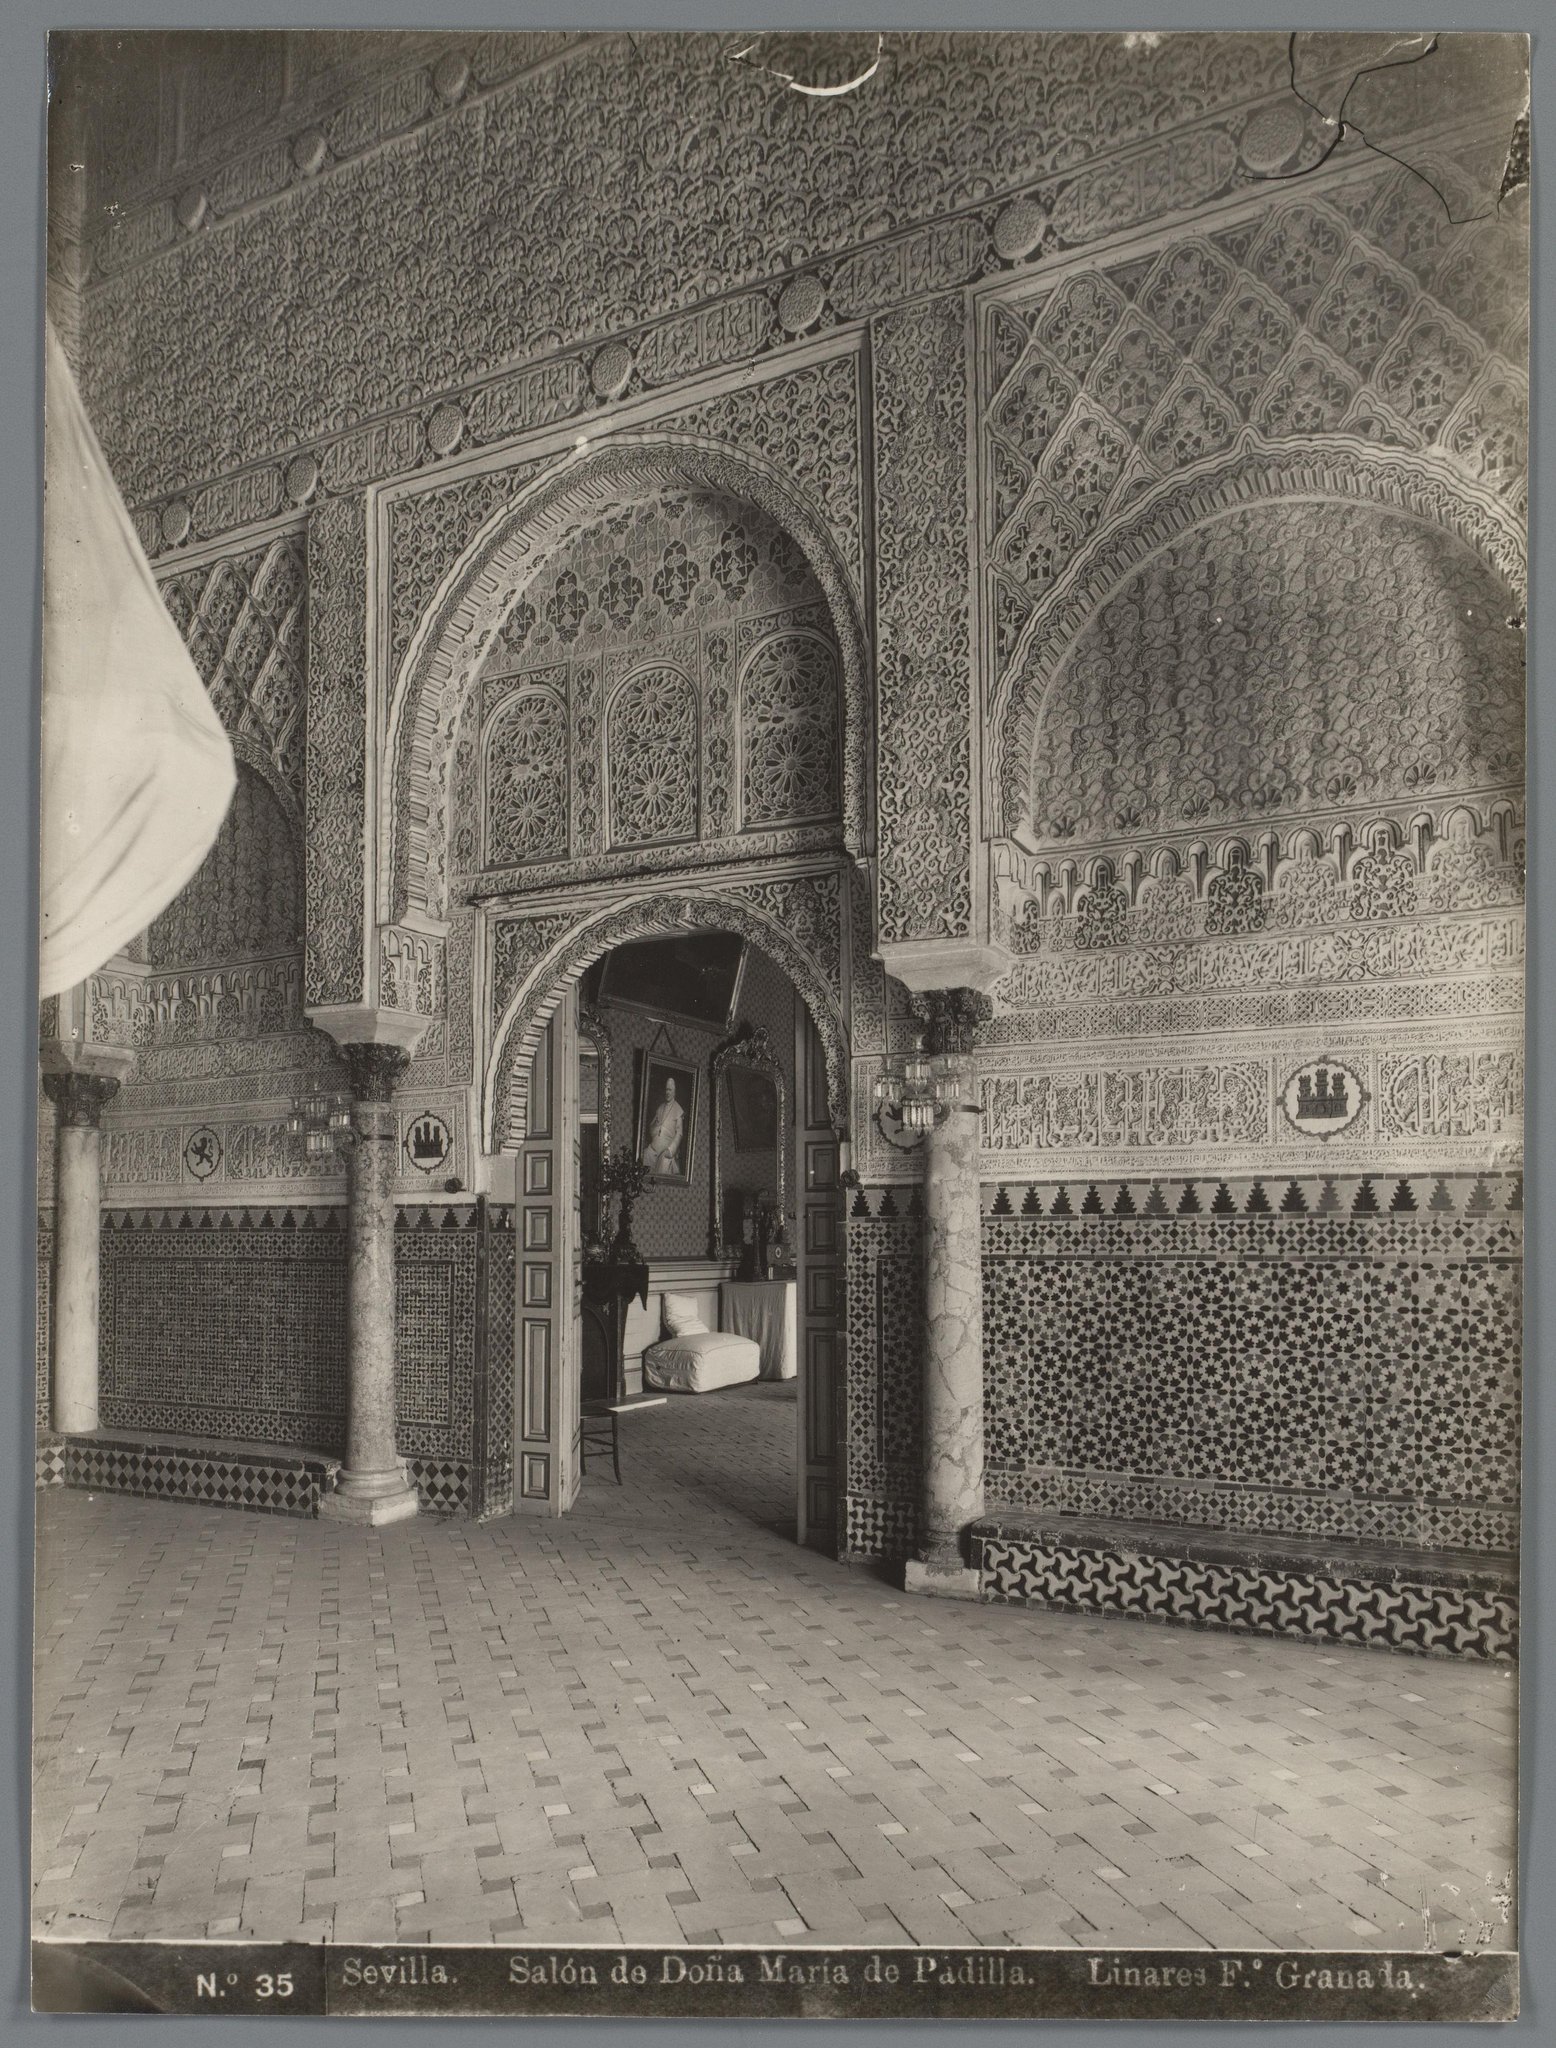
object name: photograph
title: Salón de Doña Maria de Padilla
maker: f. linares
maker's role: publisher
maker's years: 1870-1937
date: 1914-1937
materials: photographic support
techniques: gelatin silver print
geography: sevilla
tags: fortress, palace, stuccoeing, interior ~ representation of a building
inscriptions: number